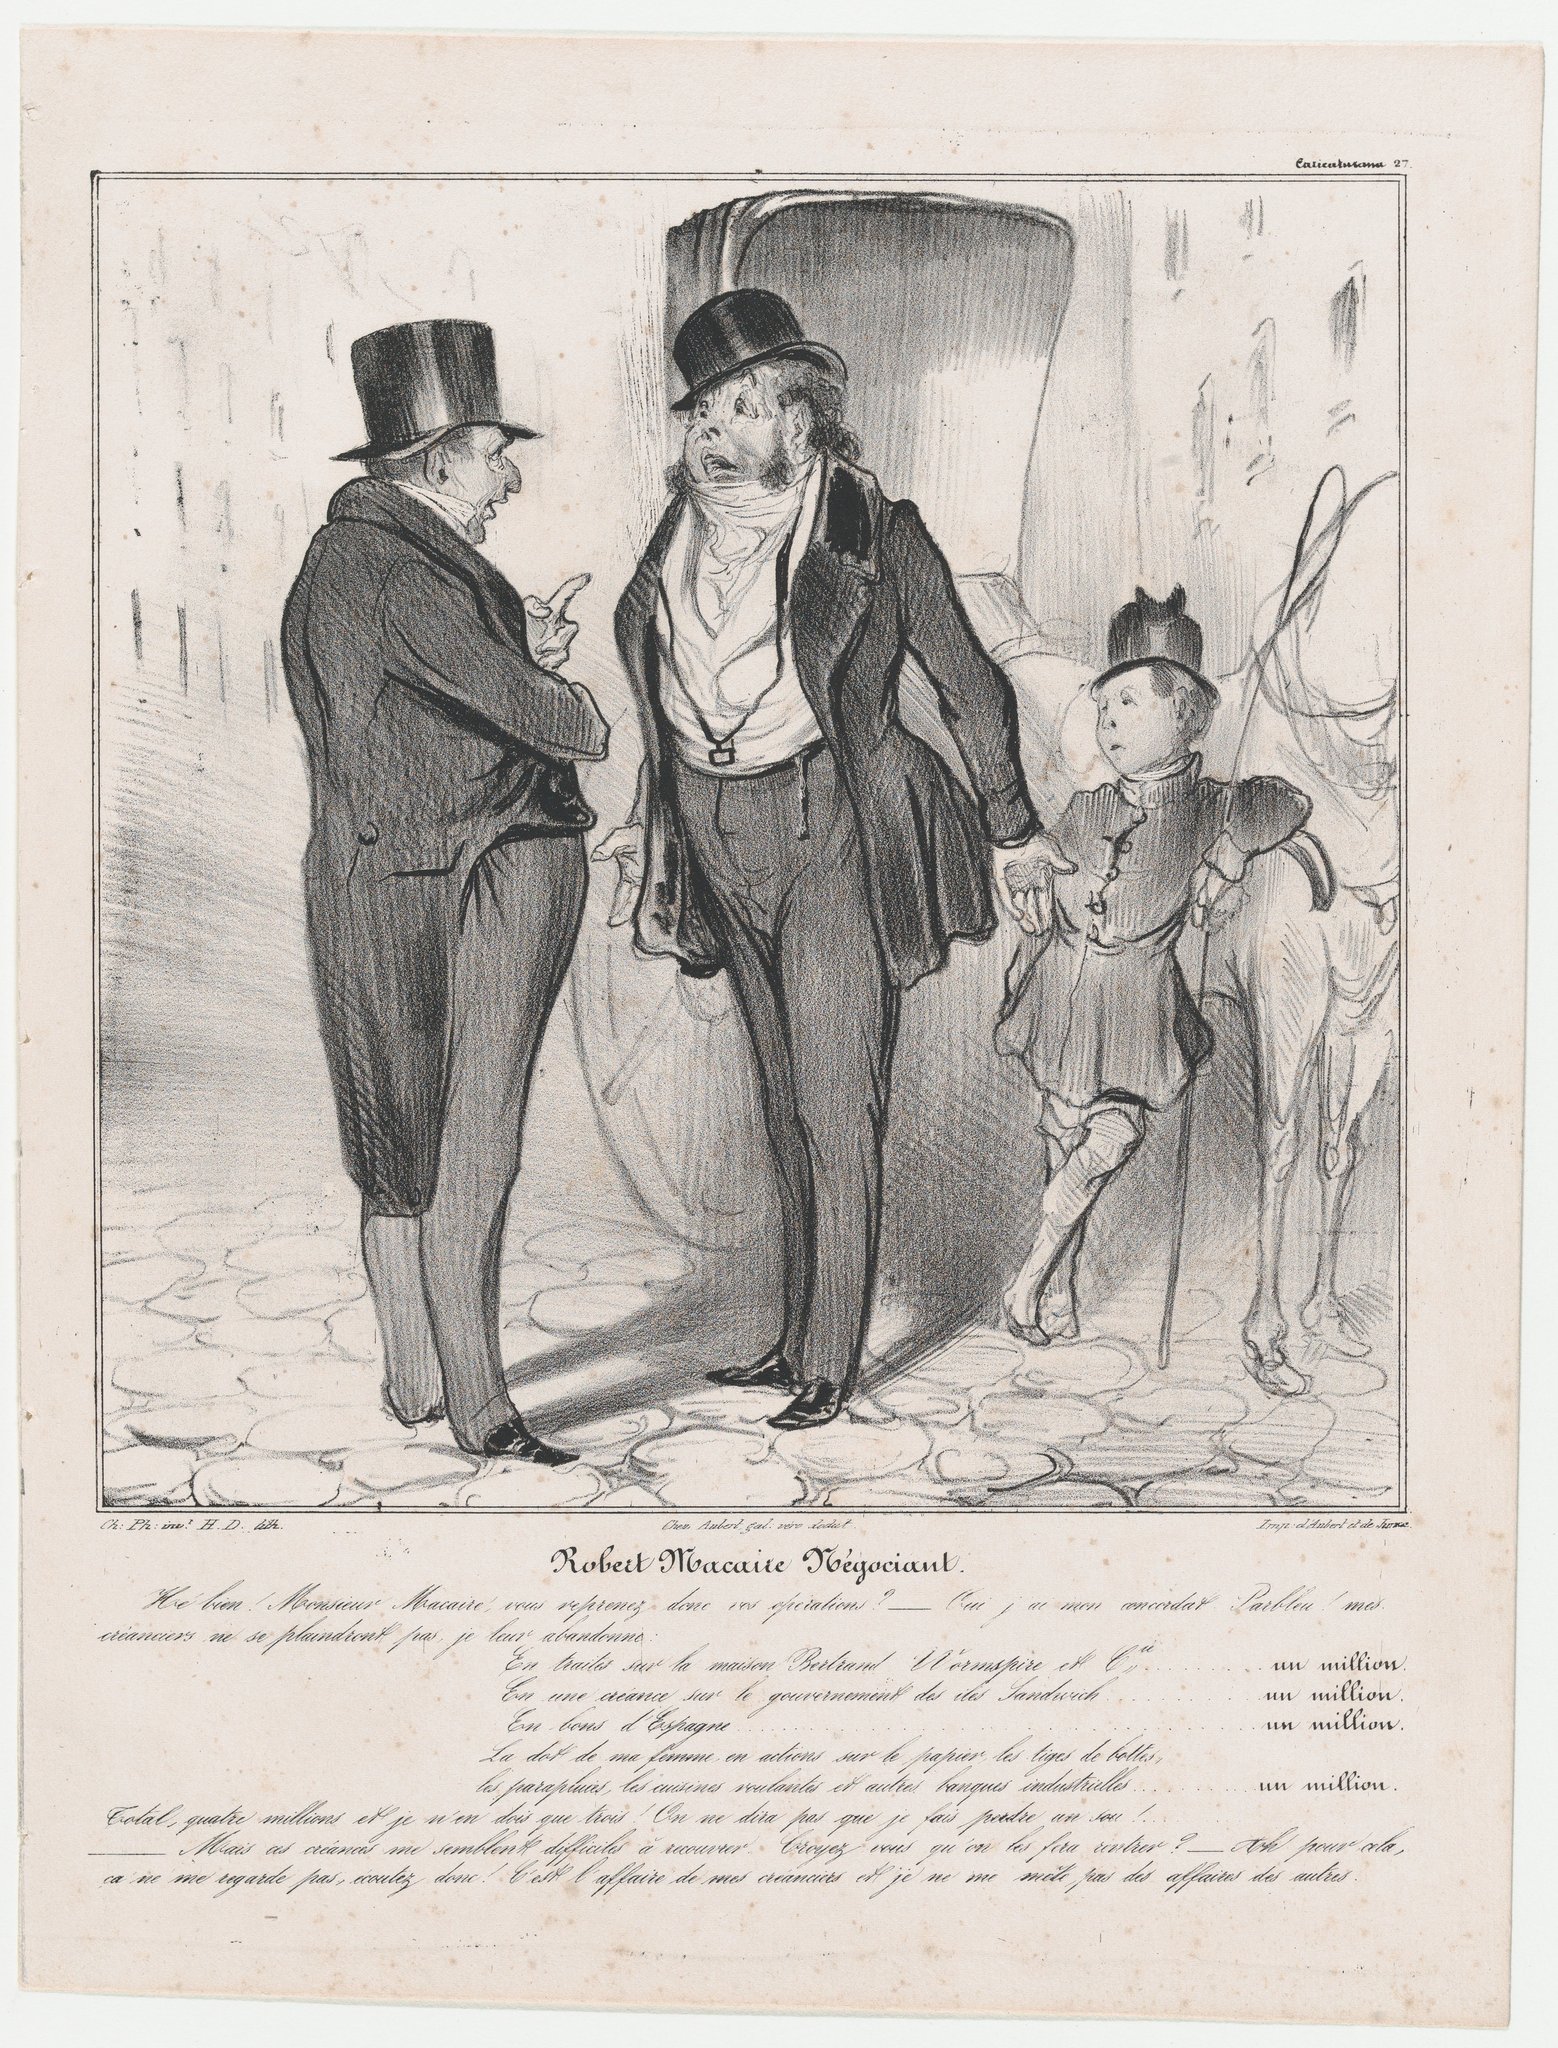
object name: print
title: Plate 27: Robert Macaire, merchant, from 'Caricaturana,' published in Les Robert Macaires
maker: honoré daumier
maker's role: artist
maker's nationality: french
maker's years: 1808-1879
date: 1838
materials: paper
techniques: lithograph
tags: satire,boys,men